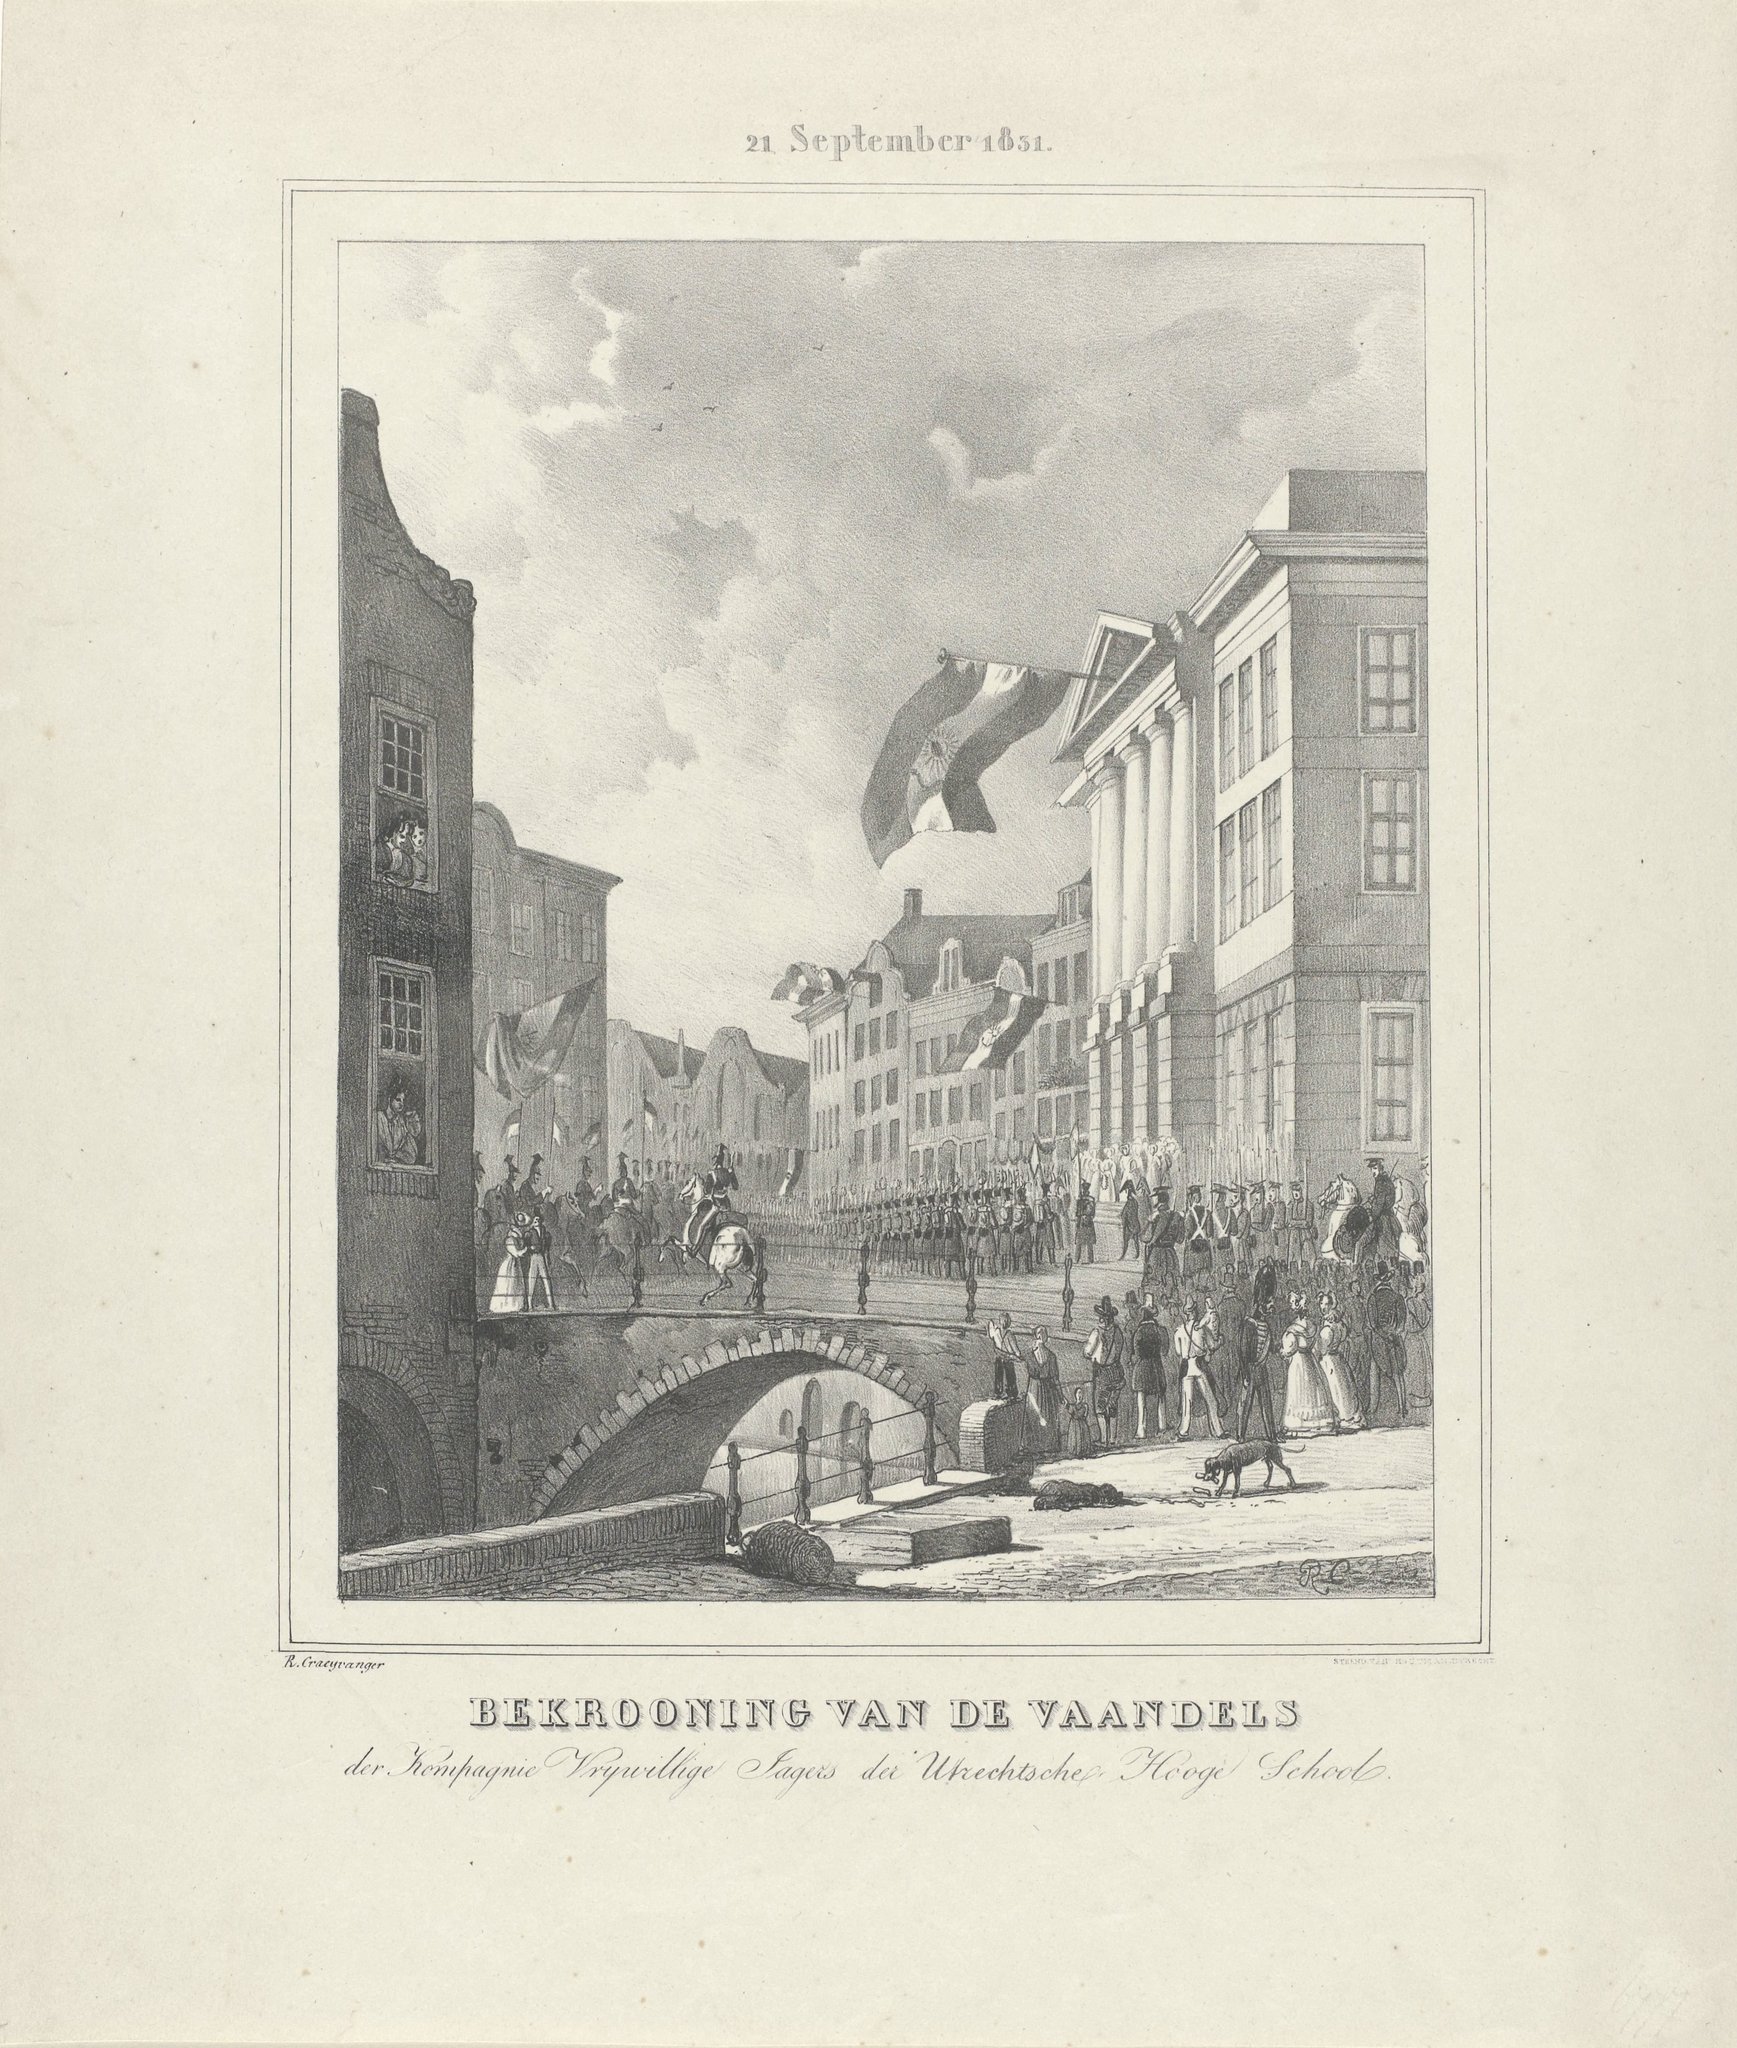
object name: print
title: Bekrooning van de Vaandels der Kompagnie Vrijwillige Jagers der Utrechtsche Hooge School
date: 1831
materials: paper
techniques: lithograph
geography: netherlands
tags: triumphal arch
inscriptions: collector's mark: Lugt 2228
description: Feestelijke verwelkoming van de teruggekeerde Compagnie Vrijwillige Jagers van de Hogeschool te Utrecht na de Tiendaagse Veldtocht, in Utrecht op 21 september 1831. De militairen ontvangen voor het Nieuwe Stadhuis op de Stadhuisbrug aan de Oudegracht een krans van een groep in het wit geklede vrouwen.